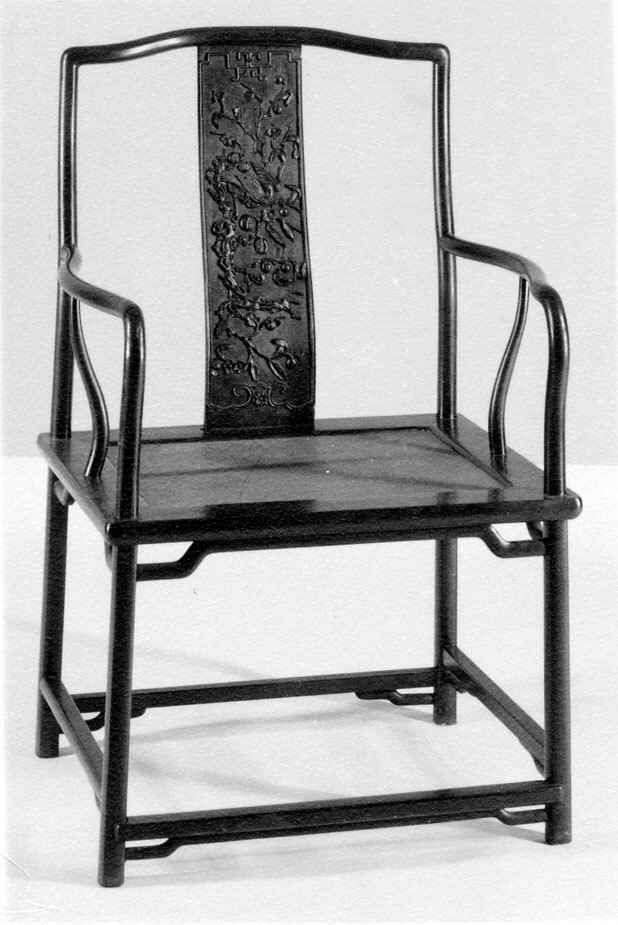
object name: armchair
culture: chinese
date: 1701-1900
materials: wood